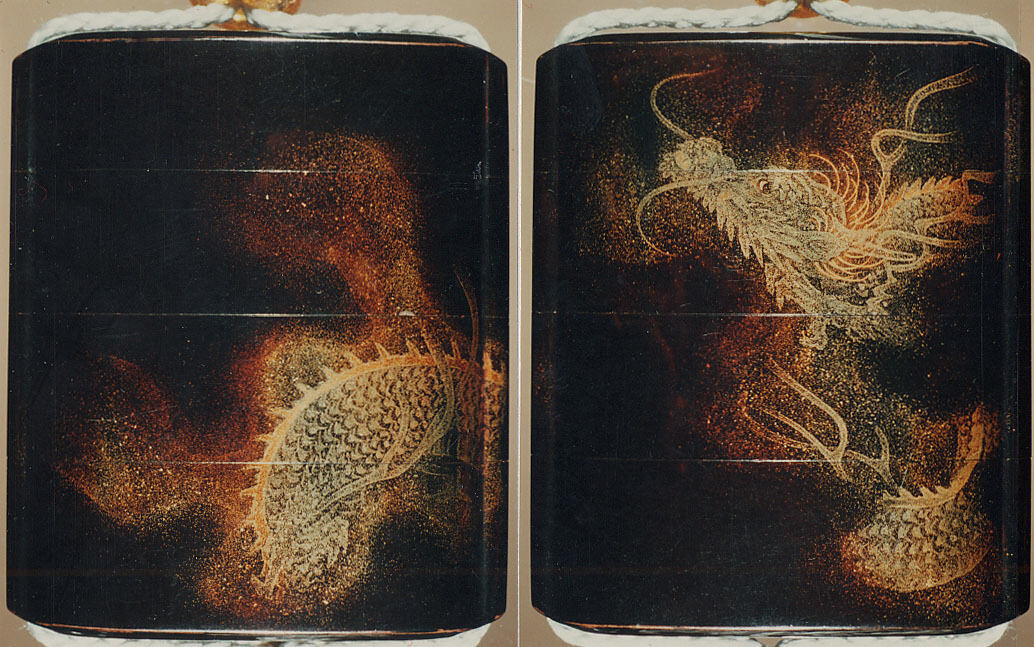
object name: inrō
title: Case (Inrō) with Design of Dragons among Clouds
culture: japanese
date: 1701-1900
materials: gold, lacquer, silver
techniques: fundame, roiro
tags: dragons